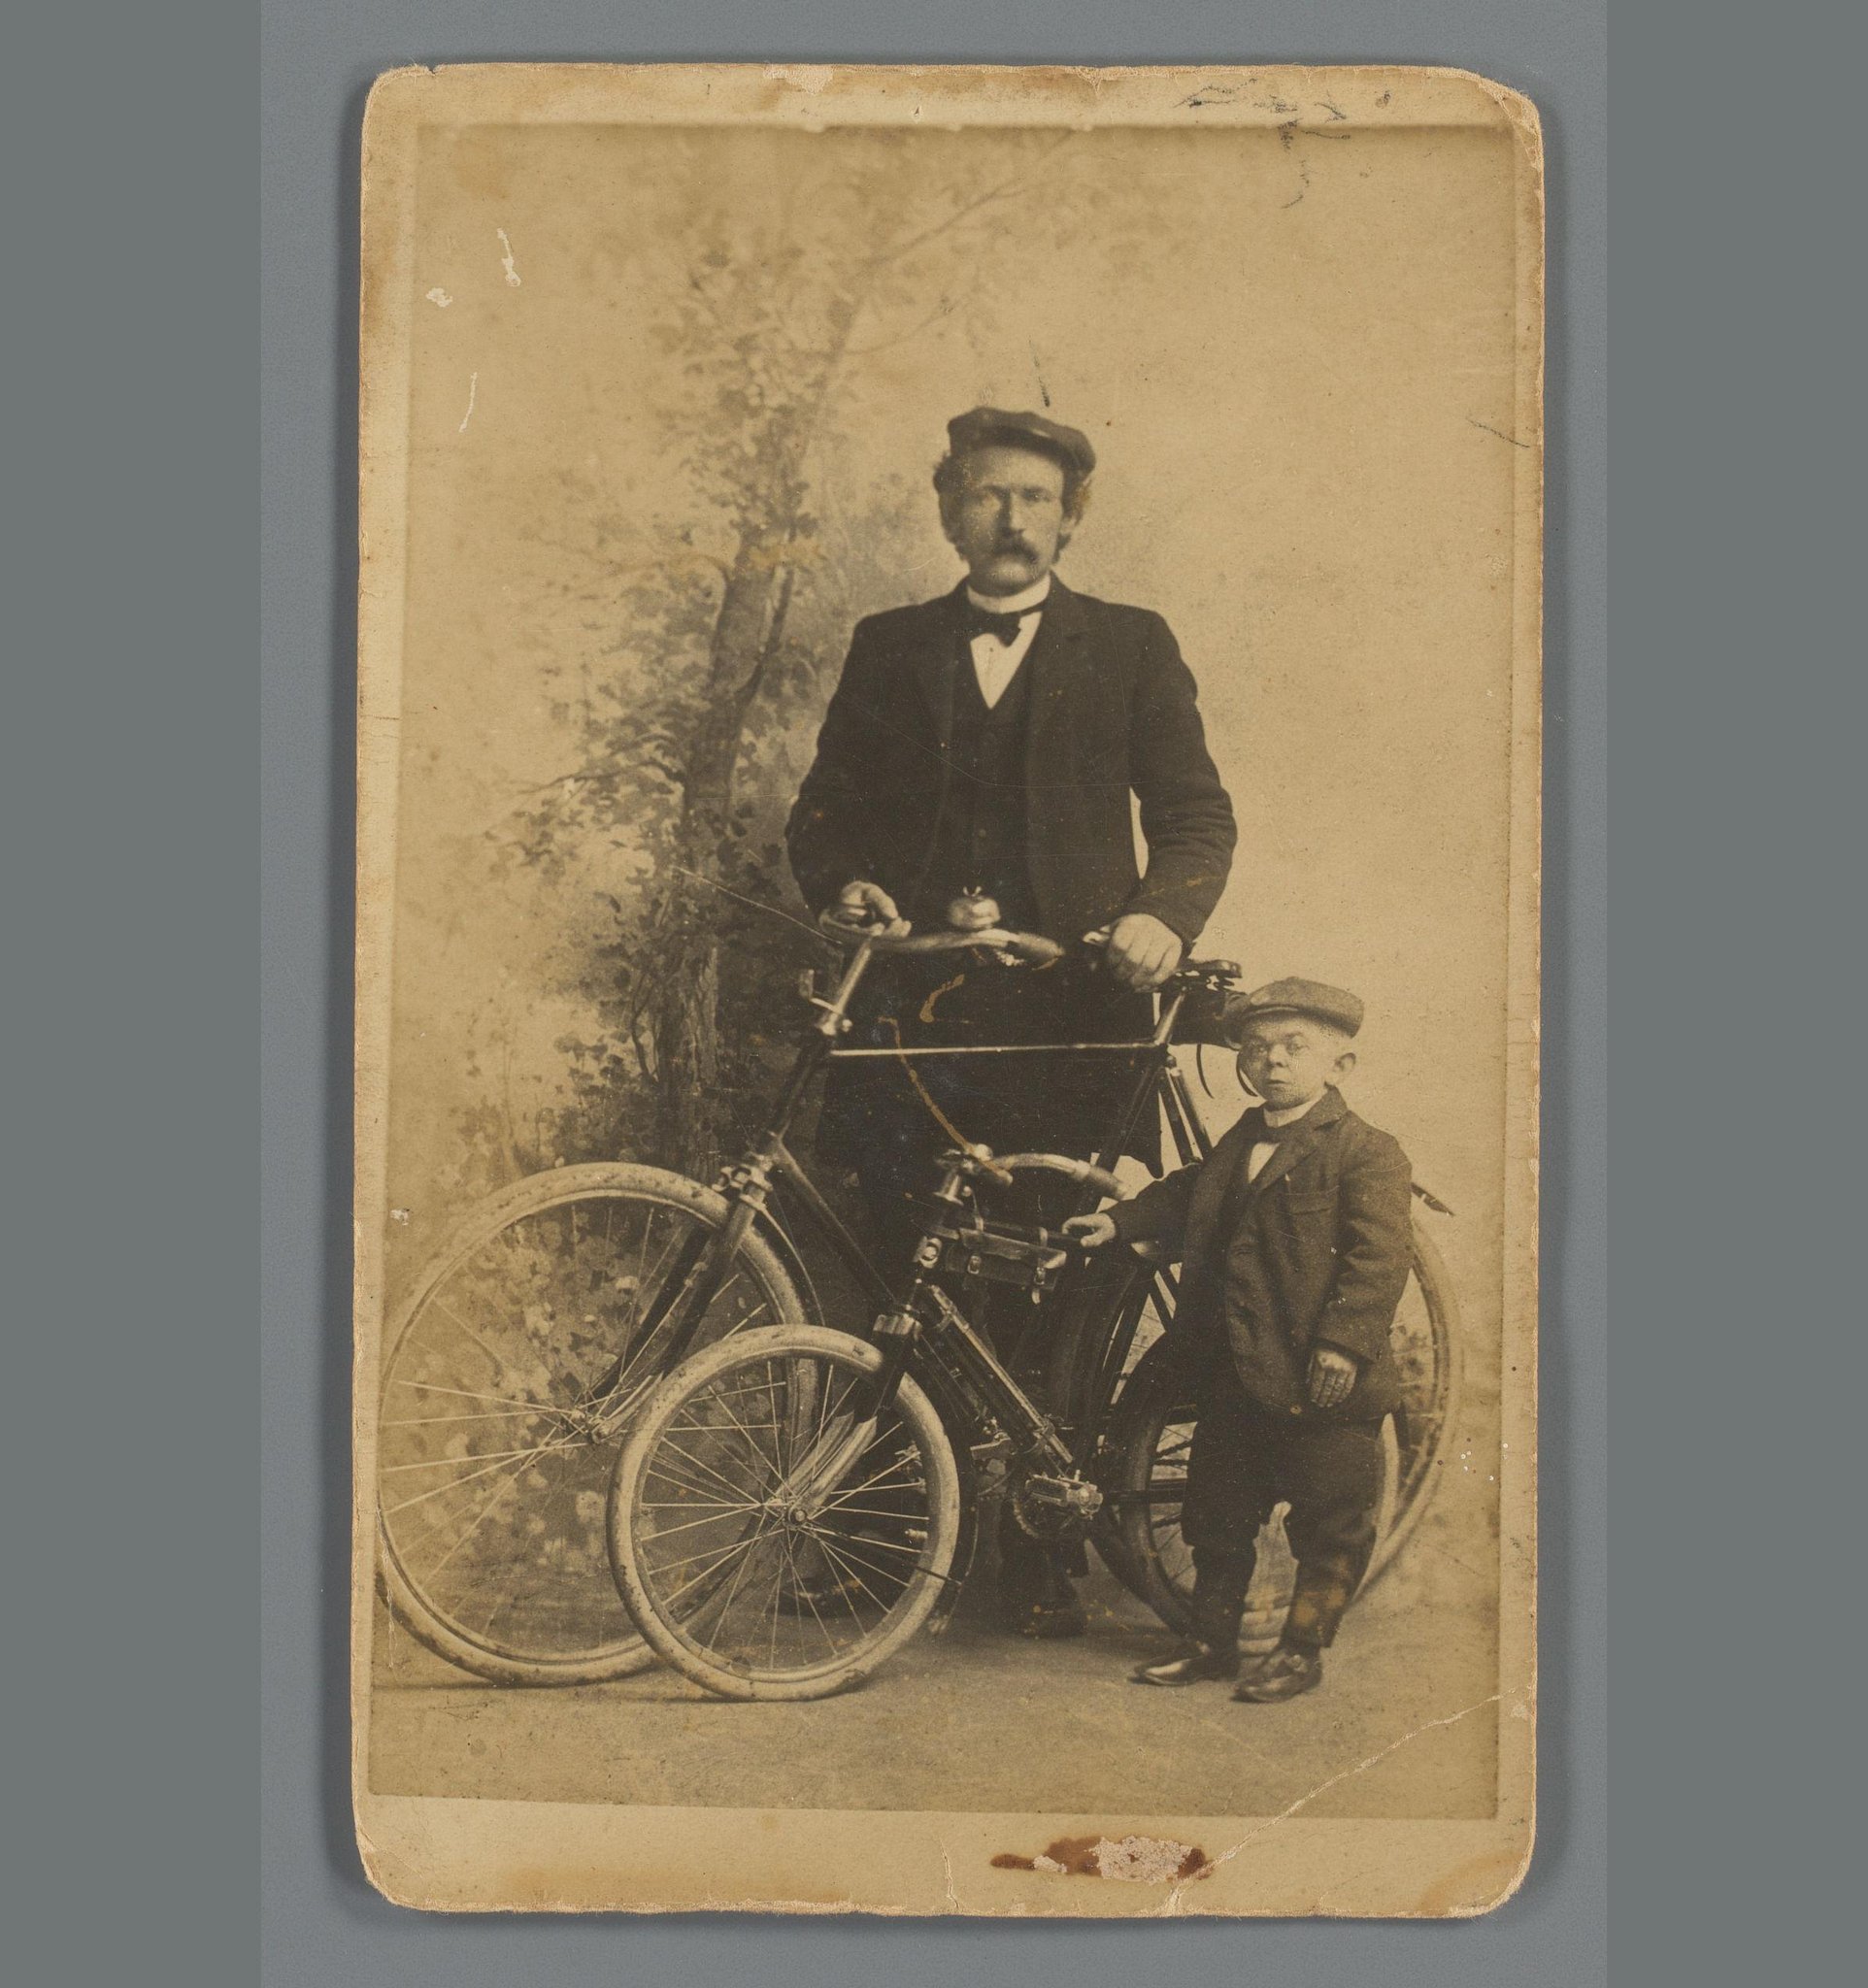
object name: ansichtkaart, prentbriefkaart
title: Portret van een onbekende grote en kleine man met fietsen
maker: Anonymous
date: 1905-1920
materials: paper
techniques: gelatin silver print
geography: netherlands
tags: little people, bicycle, historical persons not known by name, netherlands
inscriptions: inscription: ‘Kleine Kijser/ met Bas/ De kleinste/ man van/ Nederland’